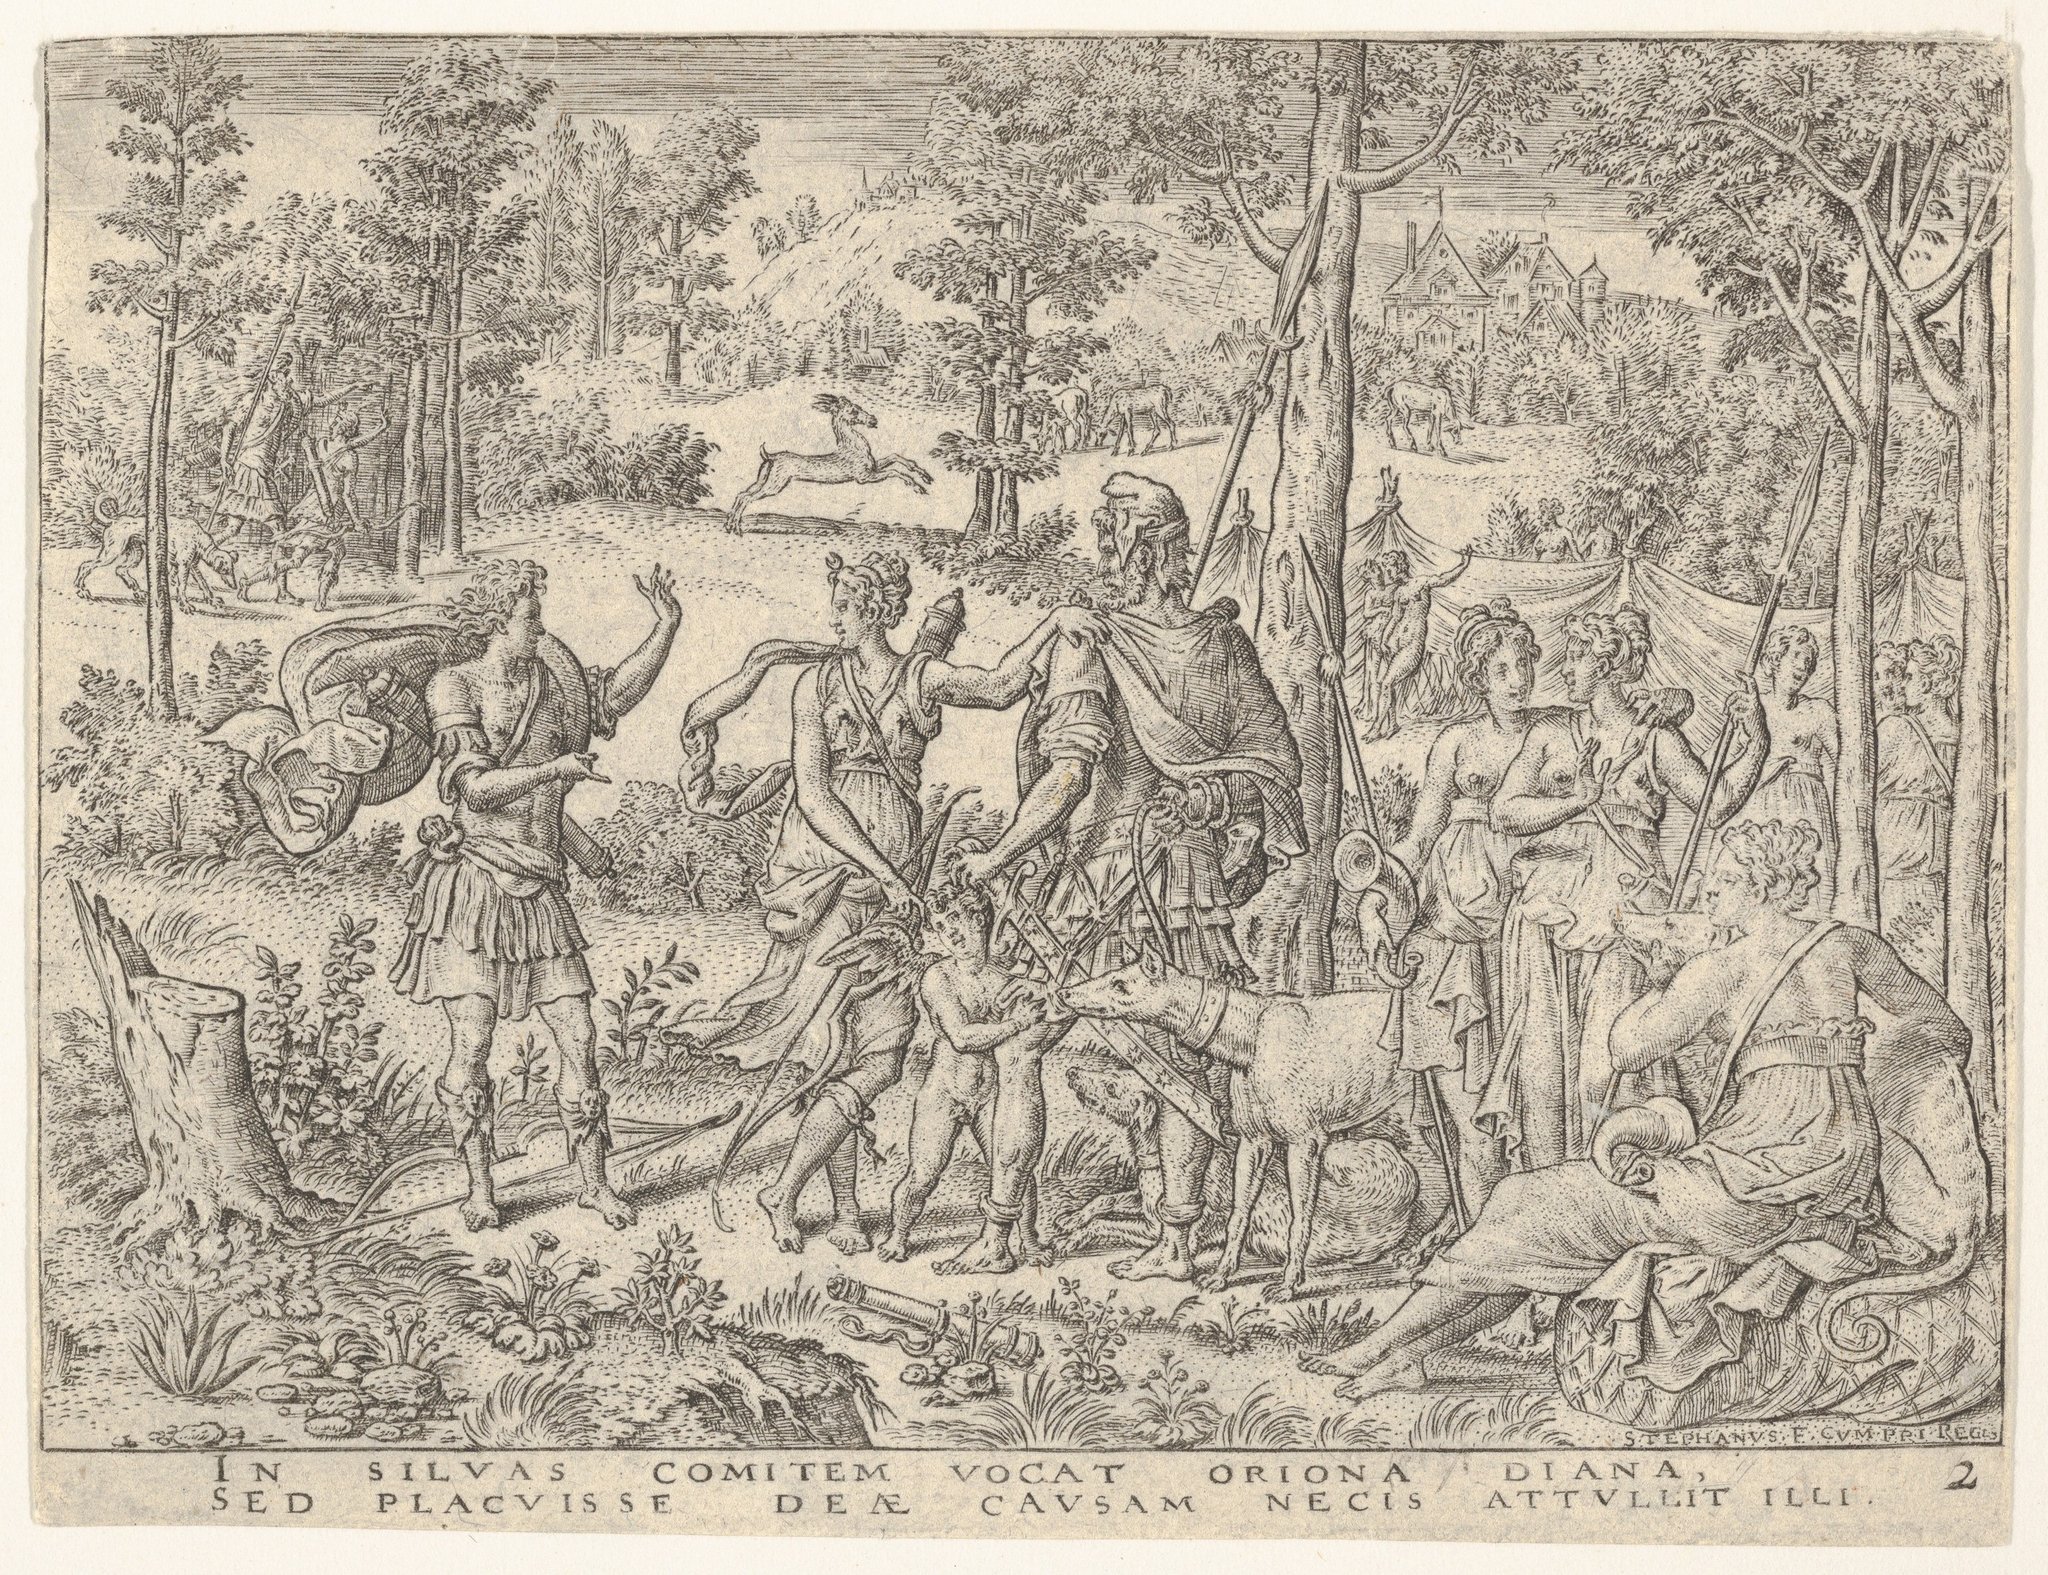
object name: print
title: Diana accepts the huntsman Orion into her company (Diane admettant en sa compagnie le chasseur orion)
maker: etienne delaune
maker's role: artist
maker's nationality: french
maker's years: 1518-1583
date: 1540-1583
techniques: etching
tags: men,women,diana,deer,dogs